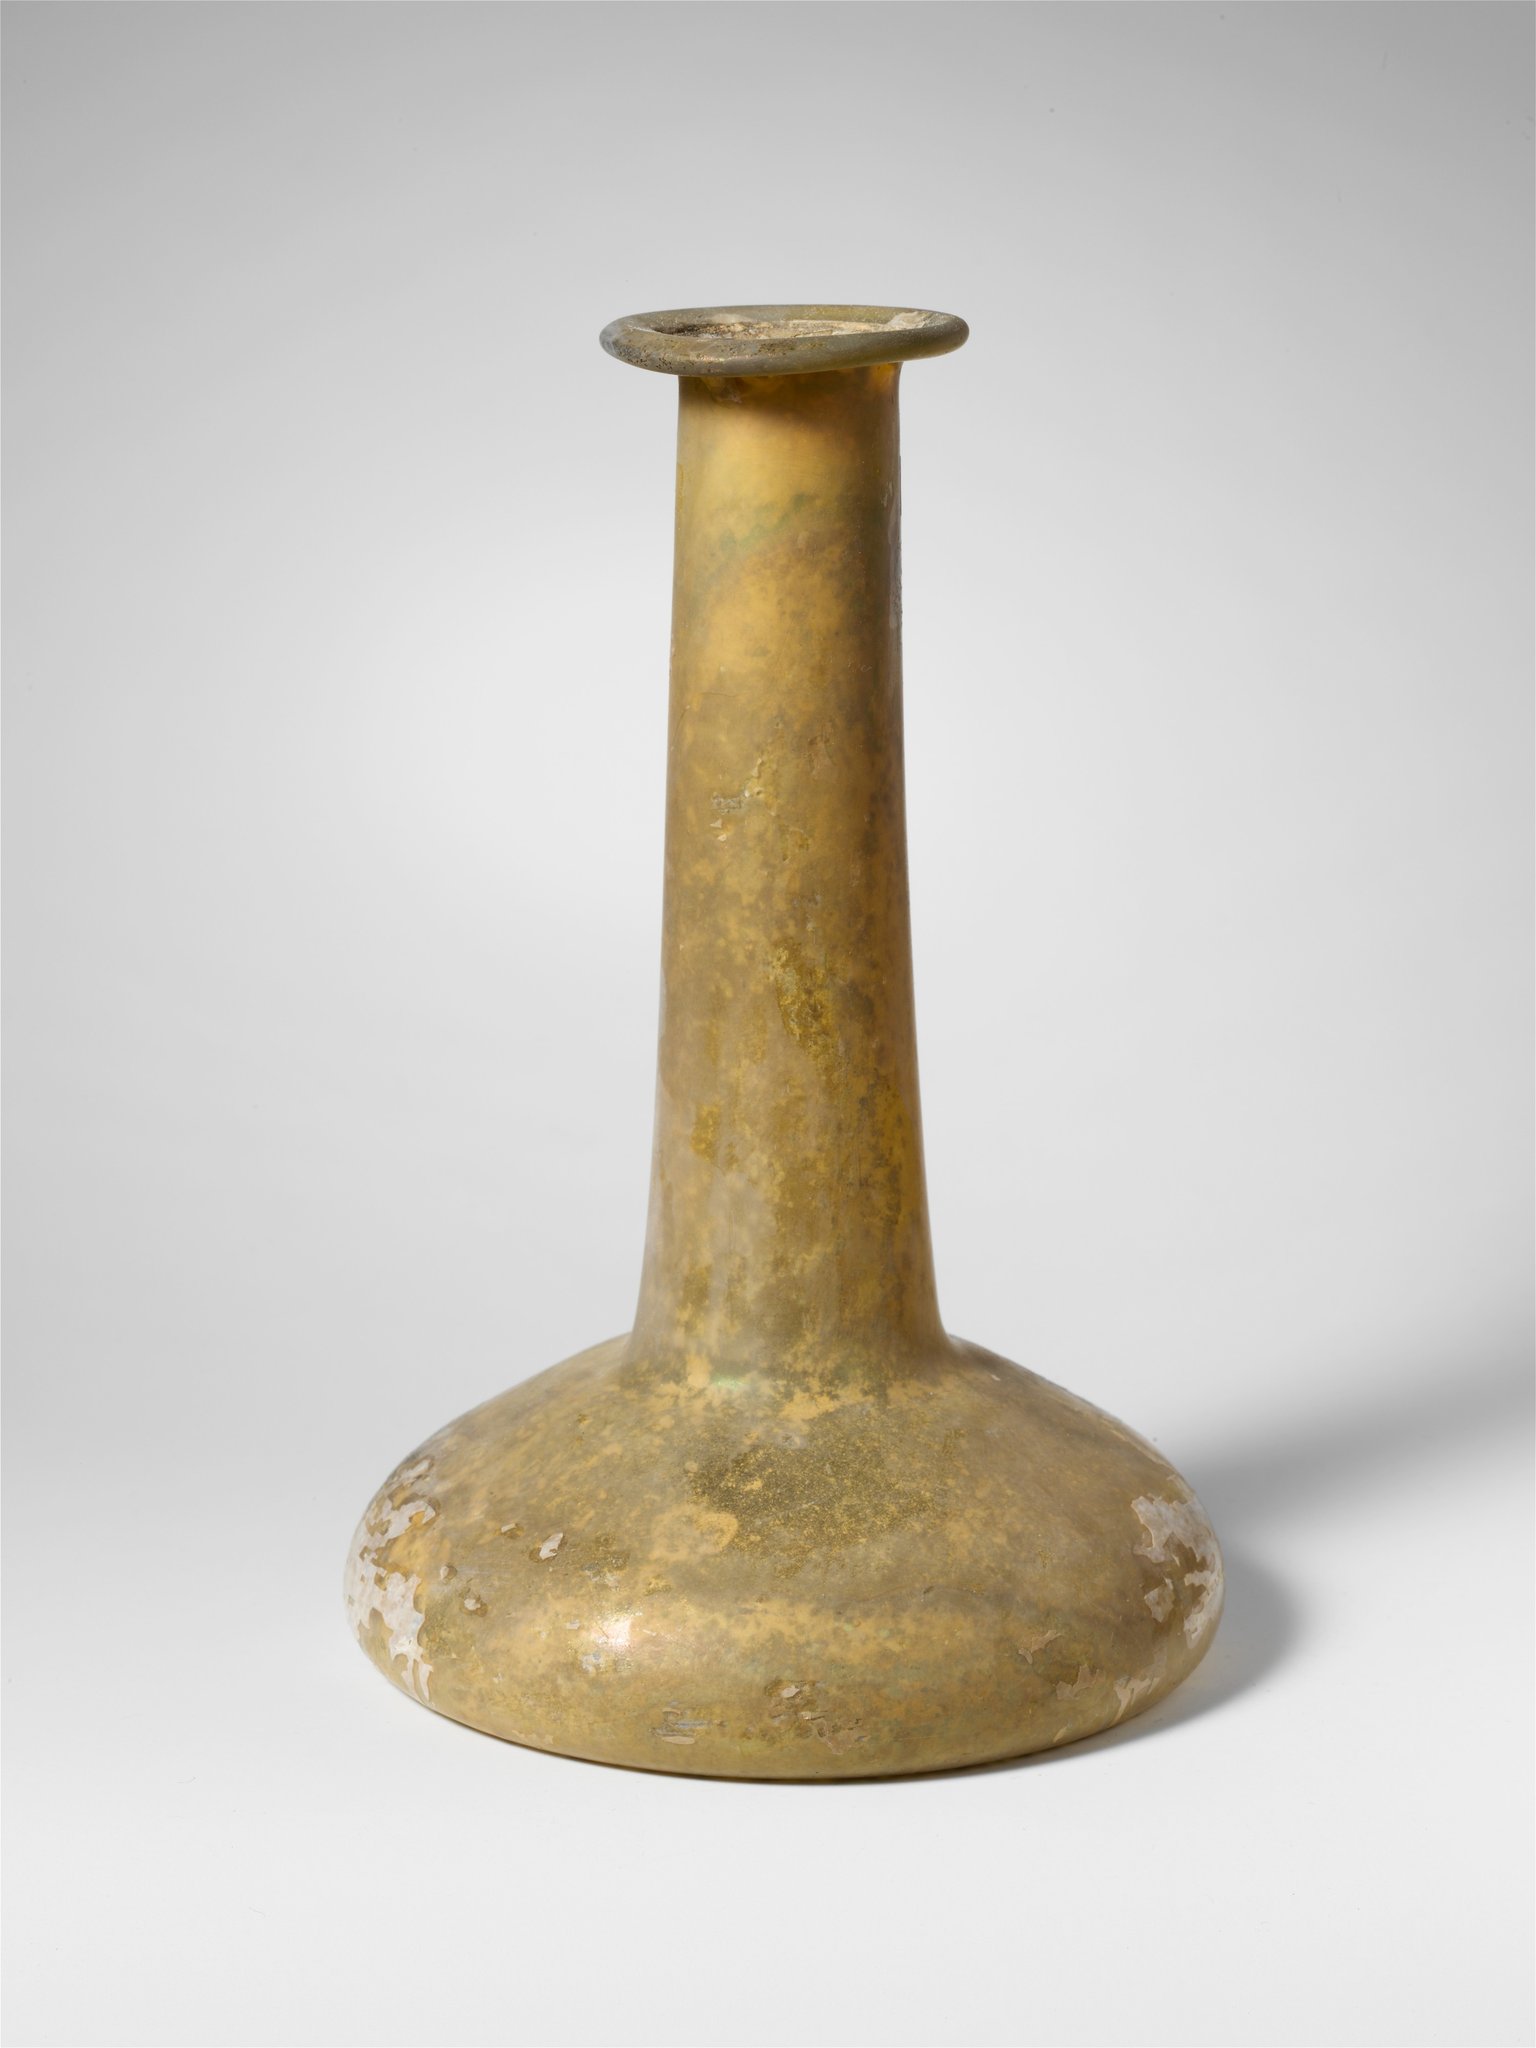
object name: perfume bottle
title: Glass perfume bottle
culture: roman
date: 101-300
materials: glass